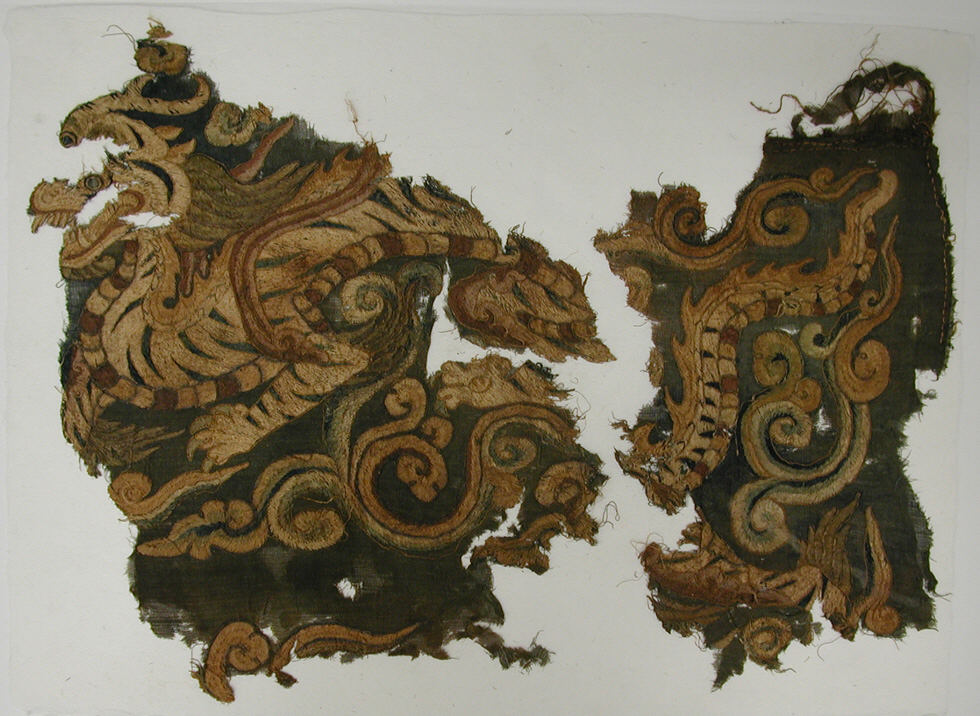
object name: textile fragment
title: Embroidery with Tiger-Dragon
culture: chinese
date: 907-1125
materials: silk, thread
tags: dragons